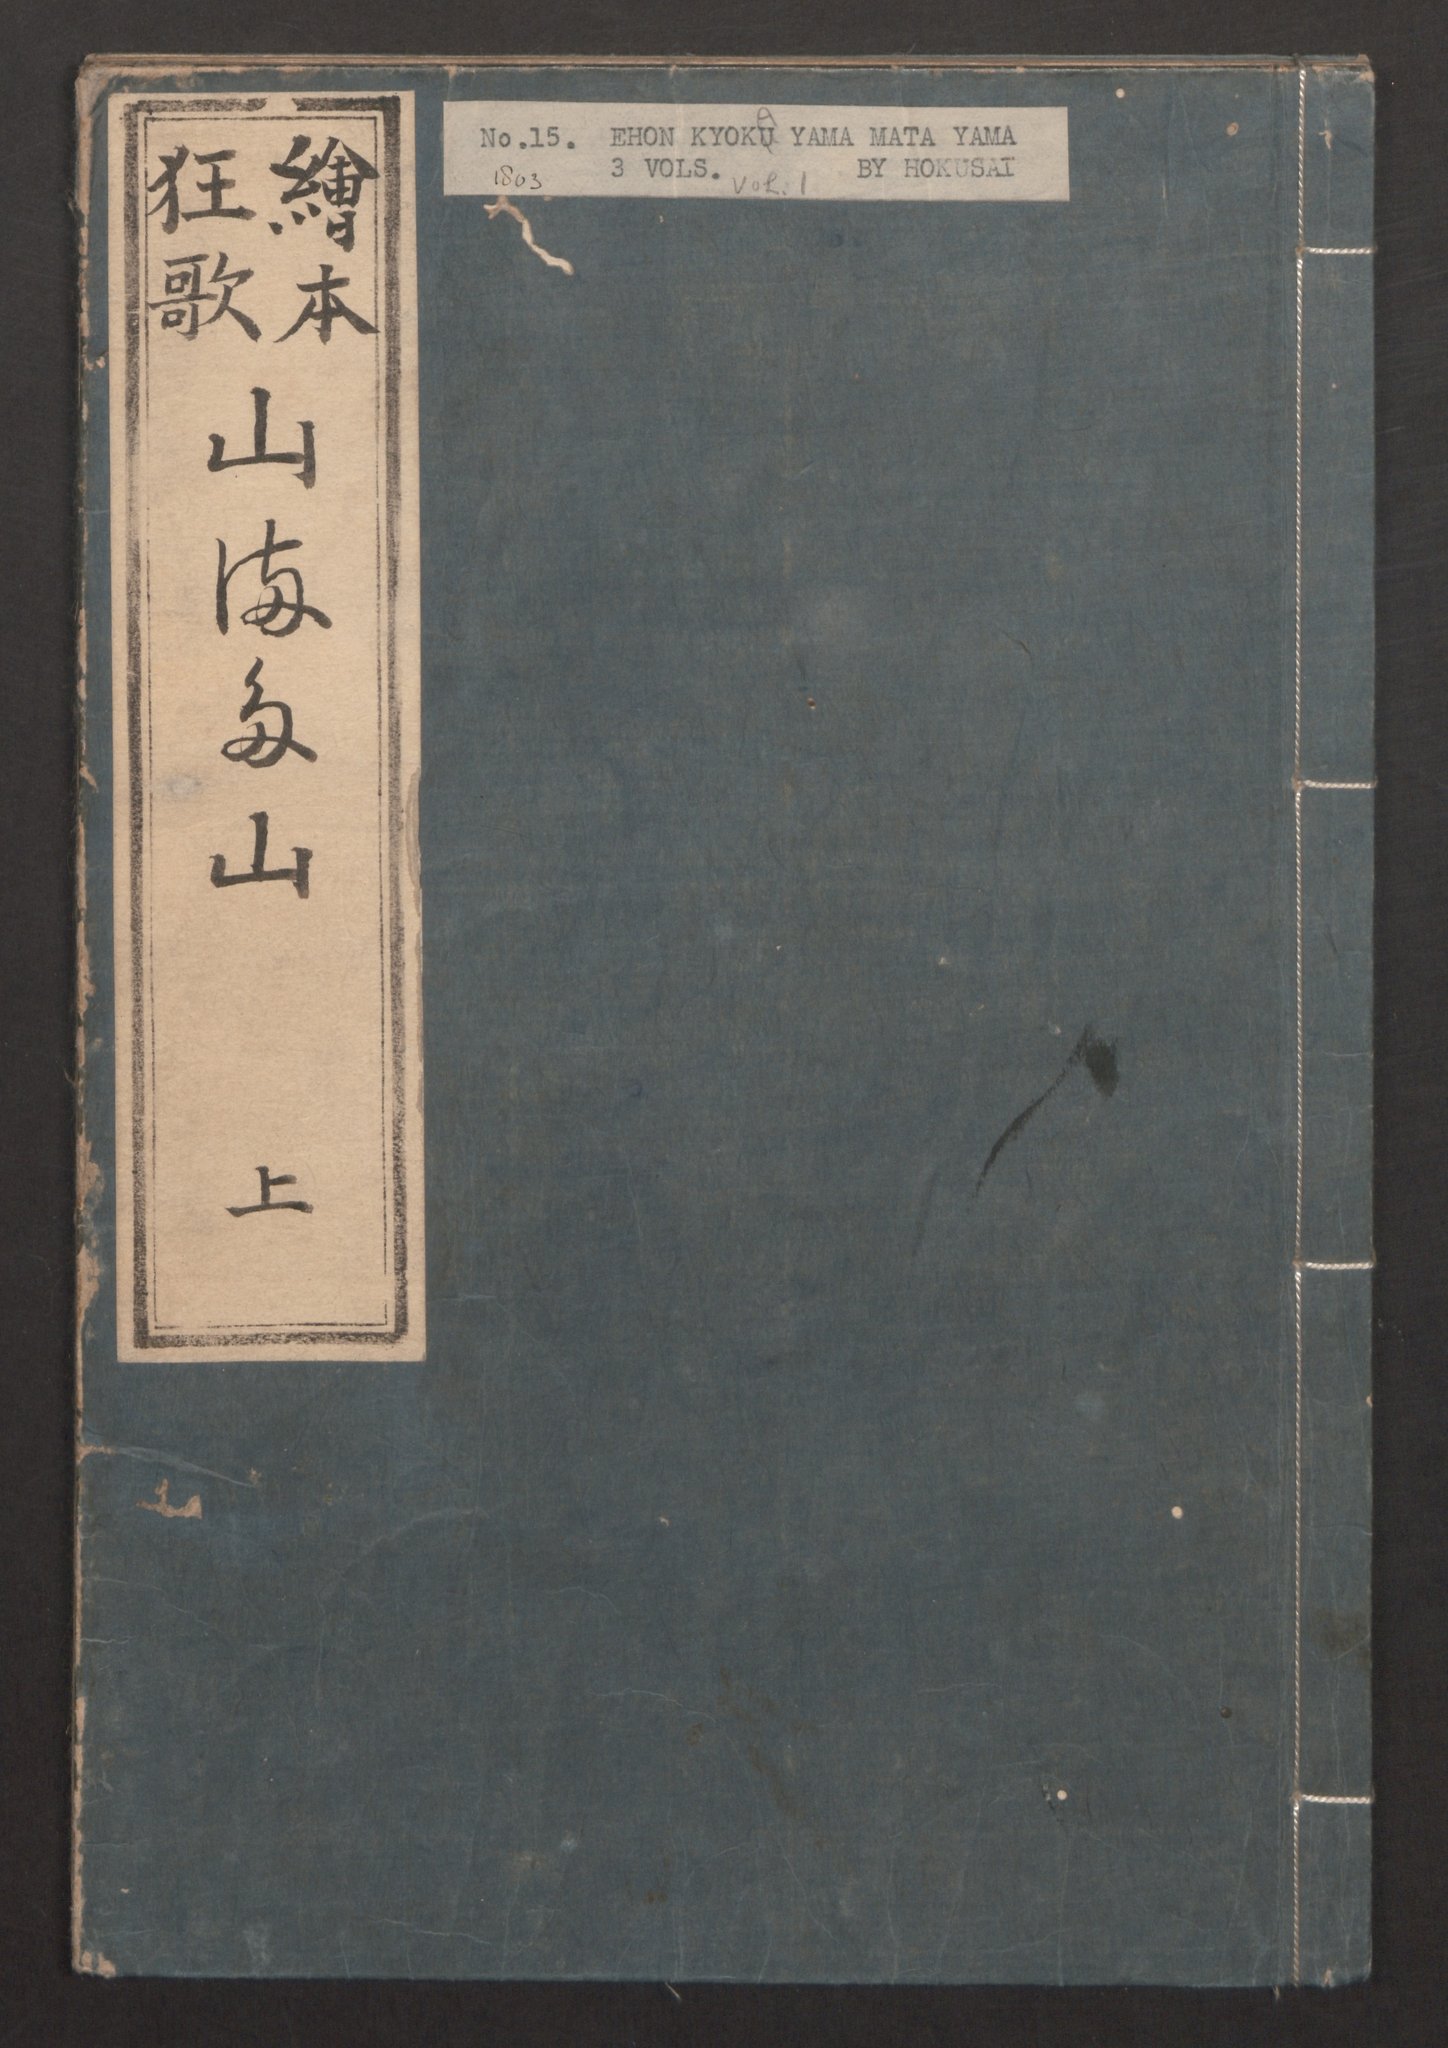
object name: illustrated book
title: Illustrated Book of Humorous Poems "Mountain on Mountain" (Ehon Kyōka yama mata yama) 絵本狂歌山満多山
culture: japanese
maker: katsushika hokusai 葛飾北斎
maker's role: artist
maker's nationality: japanese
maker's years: 1760-1849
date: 1803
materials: ink, paper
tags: poetry,women